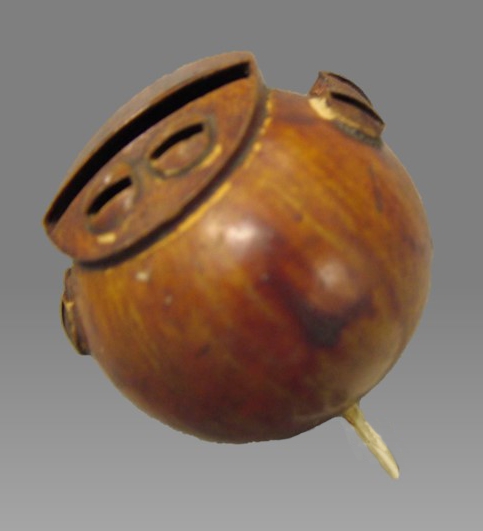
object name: ko tze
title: Ko-Tze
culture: chinese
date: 1867-1900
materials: bamboo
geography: china